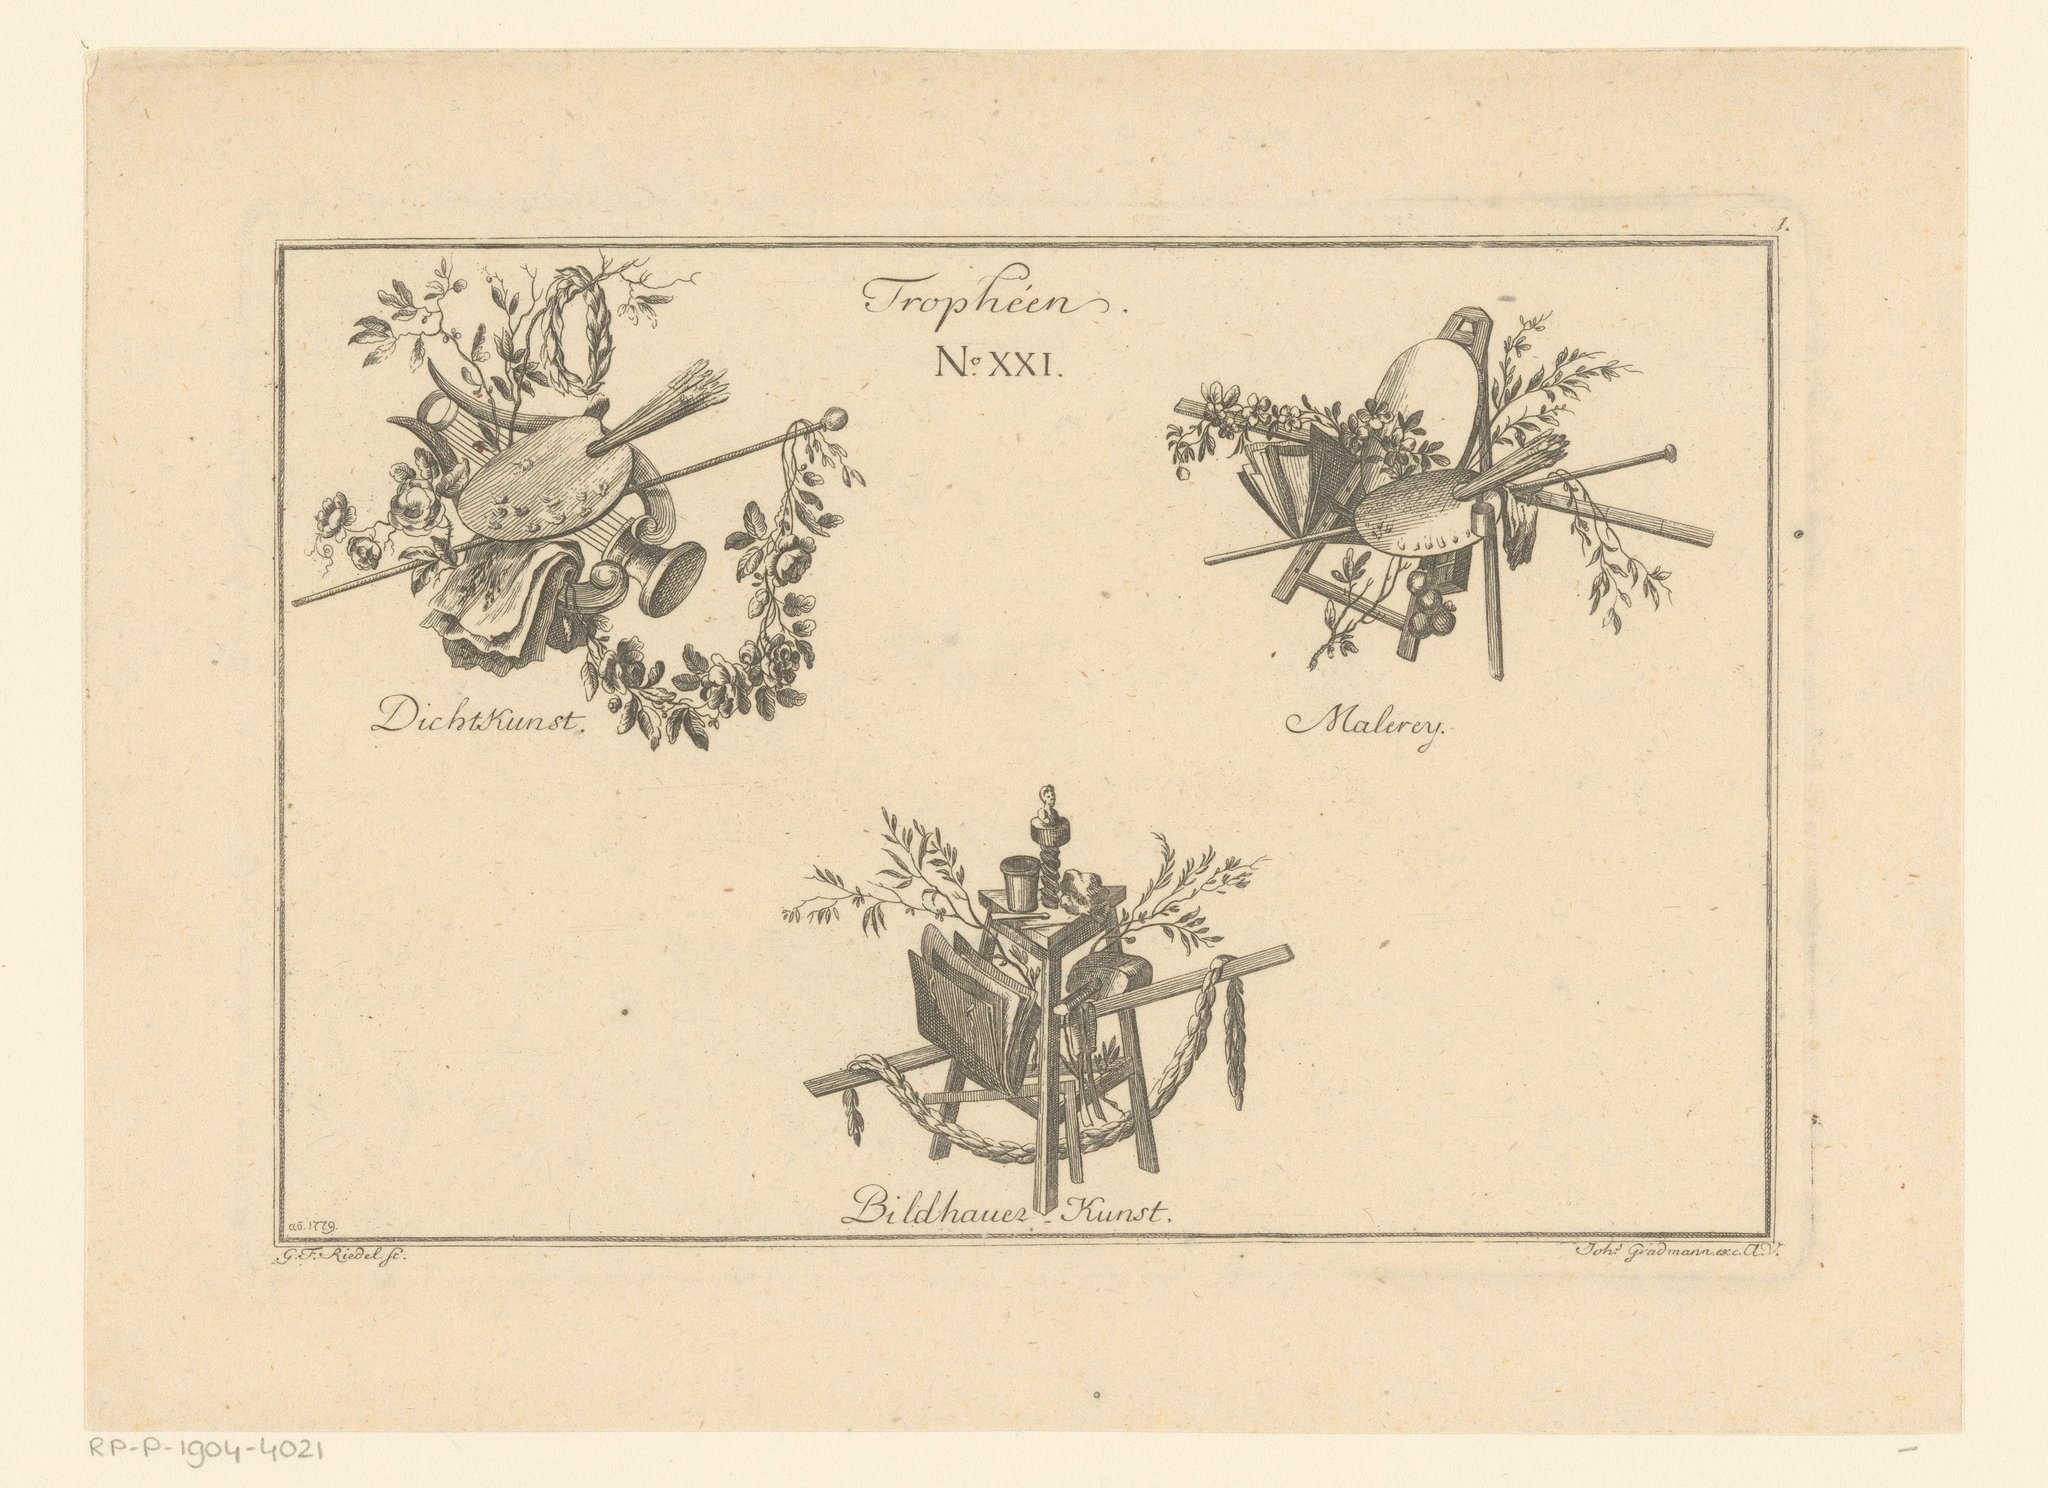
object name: ornament print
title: Dichtkunst, schilderkunst en beeldhouwkunst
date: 1779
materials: paper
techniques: etching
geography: augsburg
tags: trophy, i.e.: decorative arrangement of symbolic or typical objects ~ ornament, 'pictura', symbolic representations, allegories and emblems ~ painting; 'pittura' (ripa), 'sculptura', symbolic representations, allegories and emblems ~ sculpture; 'scoltura' (ripa), symbolic representations, allegories and emblems ~ poetry; 'poesia' (ripa)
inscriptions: collector's mark: Lugt 2228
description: Drie trofeeën. Links boven met attributen behorende bij dichtkunst, rechts boven bij schilderkunst en midden onder bij beeldhouwkunst. Uitgeversnummer XXI.